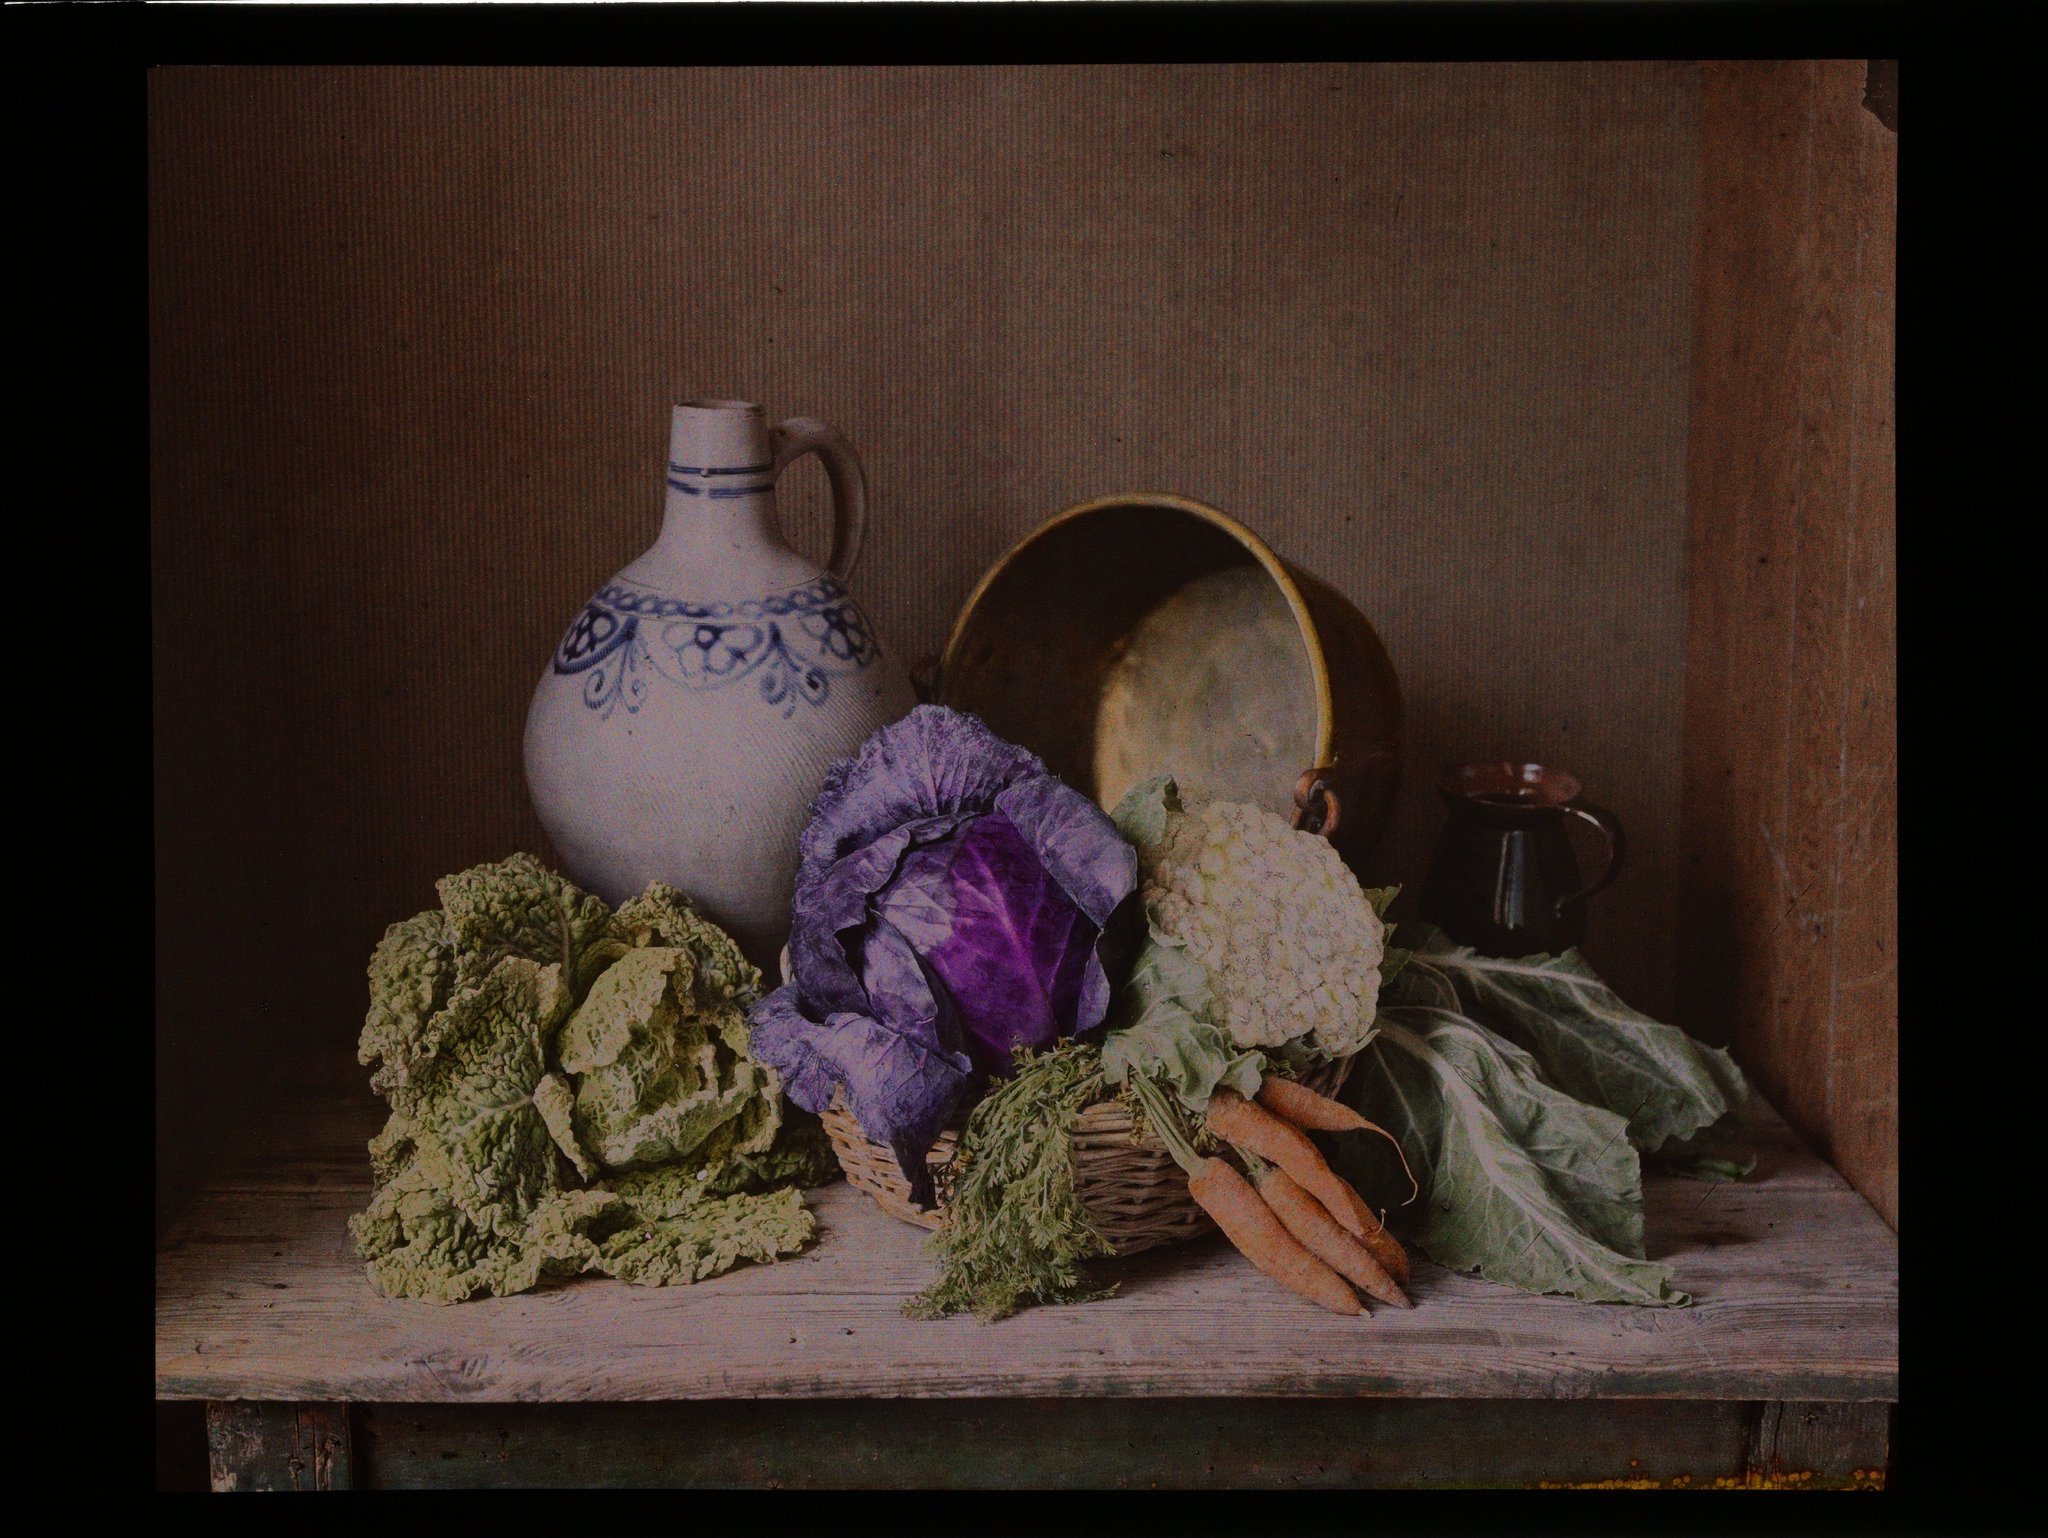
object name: photograph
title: Stilleven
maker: Anonymous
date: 1907-1935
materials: glass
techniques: autochrome process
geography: netherlands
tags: vegetables, foodstuffs; still life of foodstuffs, netherlands